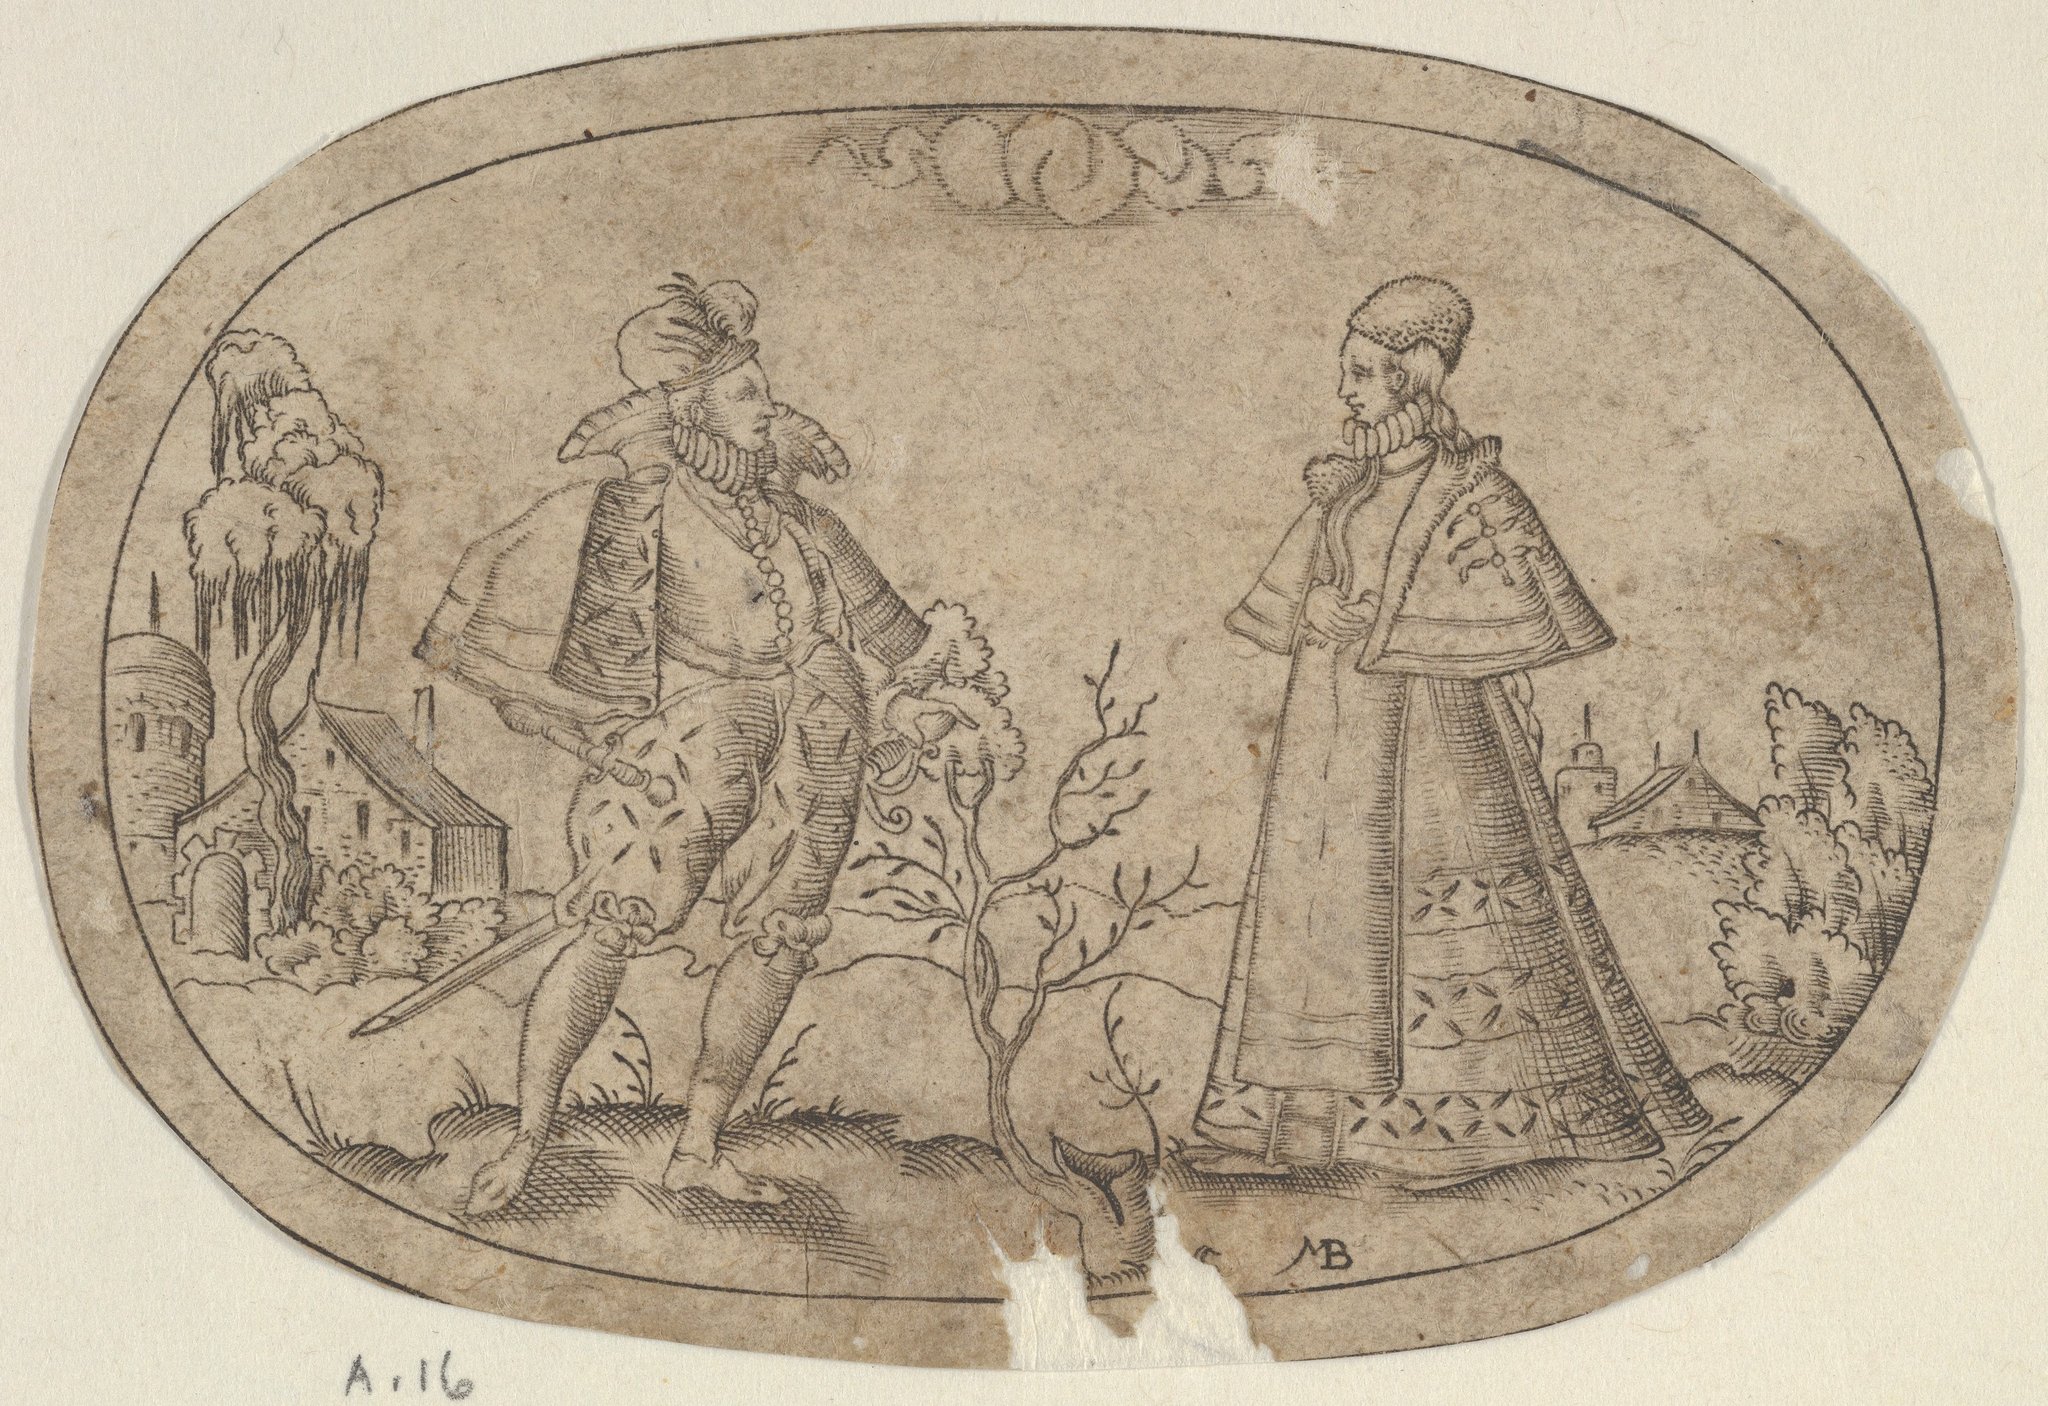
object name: print ornament architecture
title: A Gentleman and a Lady, from Das Bossenbüchlein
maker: mathais beitler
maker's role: artist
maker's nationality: german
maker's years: 1582-1616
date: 1582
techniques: engraving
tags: men,women